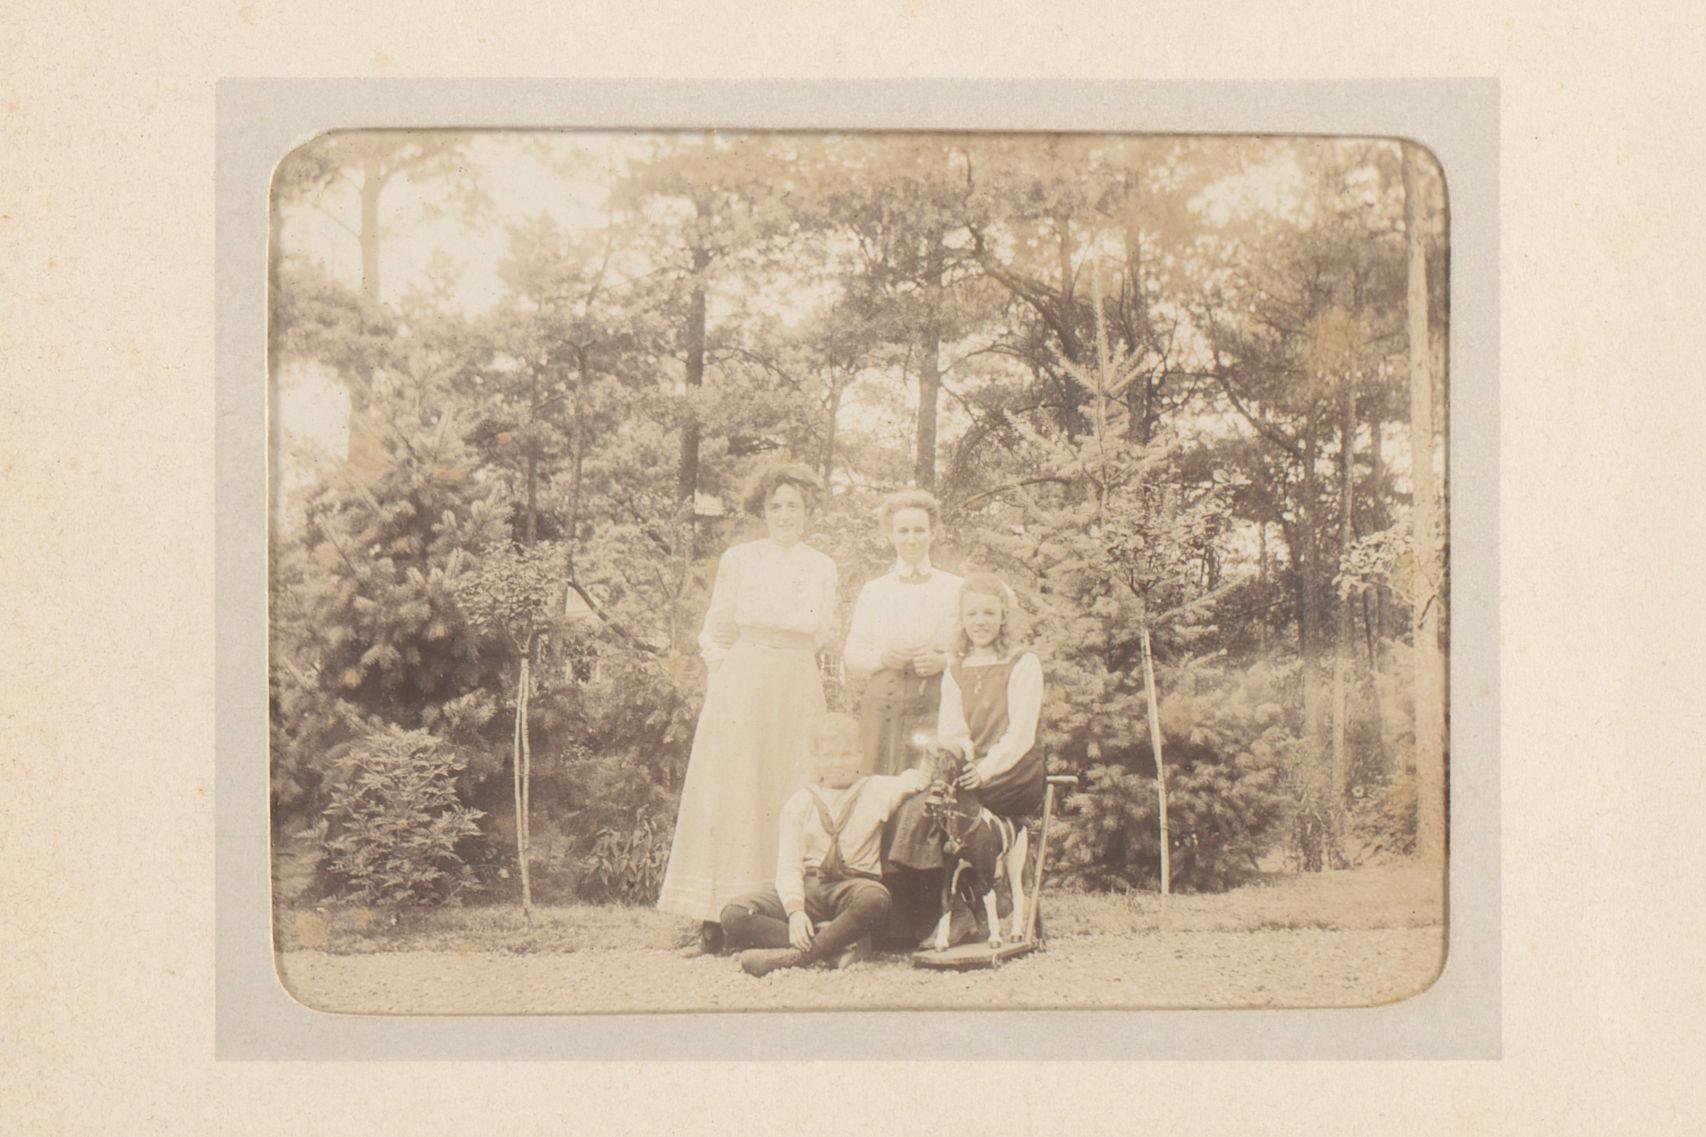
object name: photograph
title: Groepsportret van twee vrouwen, een jongen en een meisje in een tuin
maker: liesbeth overhoff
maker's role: fotograaf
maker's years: 1895-1969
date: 1911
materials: paper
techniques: gelatin silver print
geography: hilversum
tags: boy (child between toddler and youth), garden, historical persons, girl (child between toddler and youth), adult woman (+ two persons)